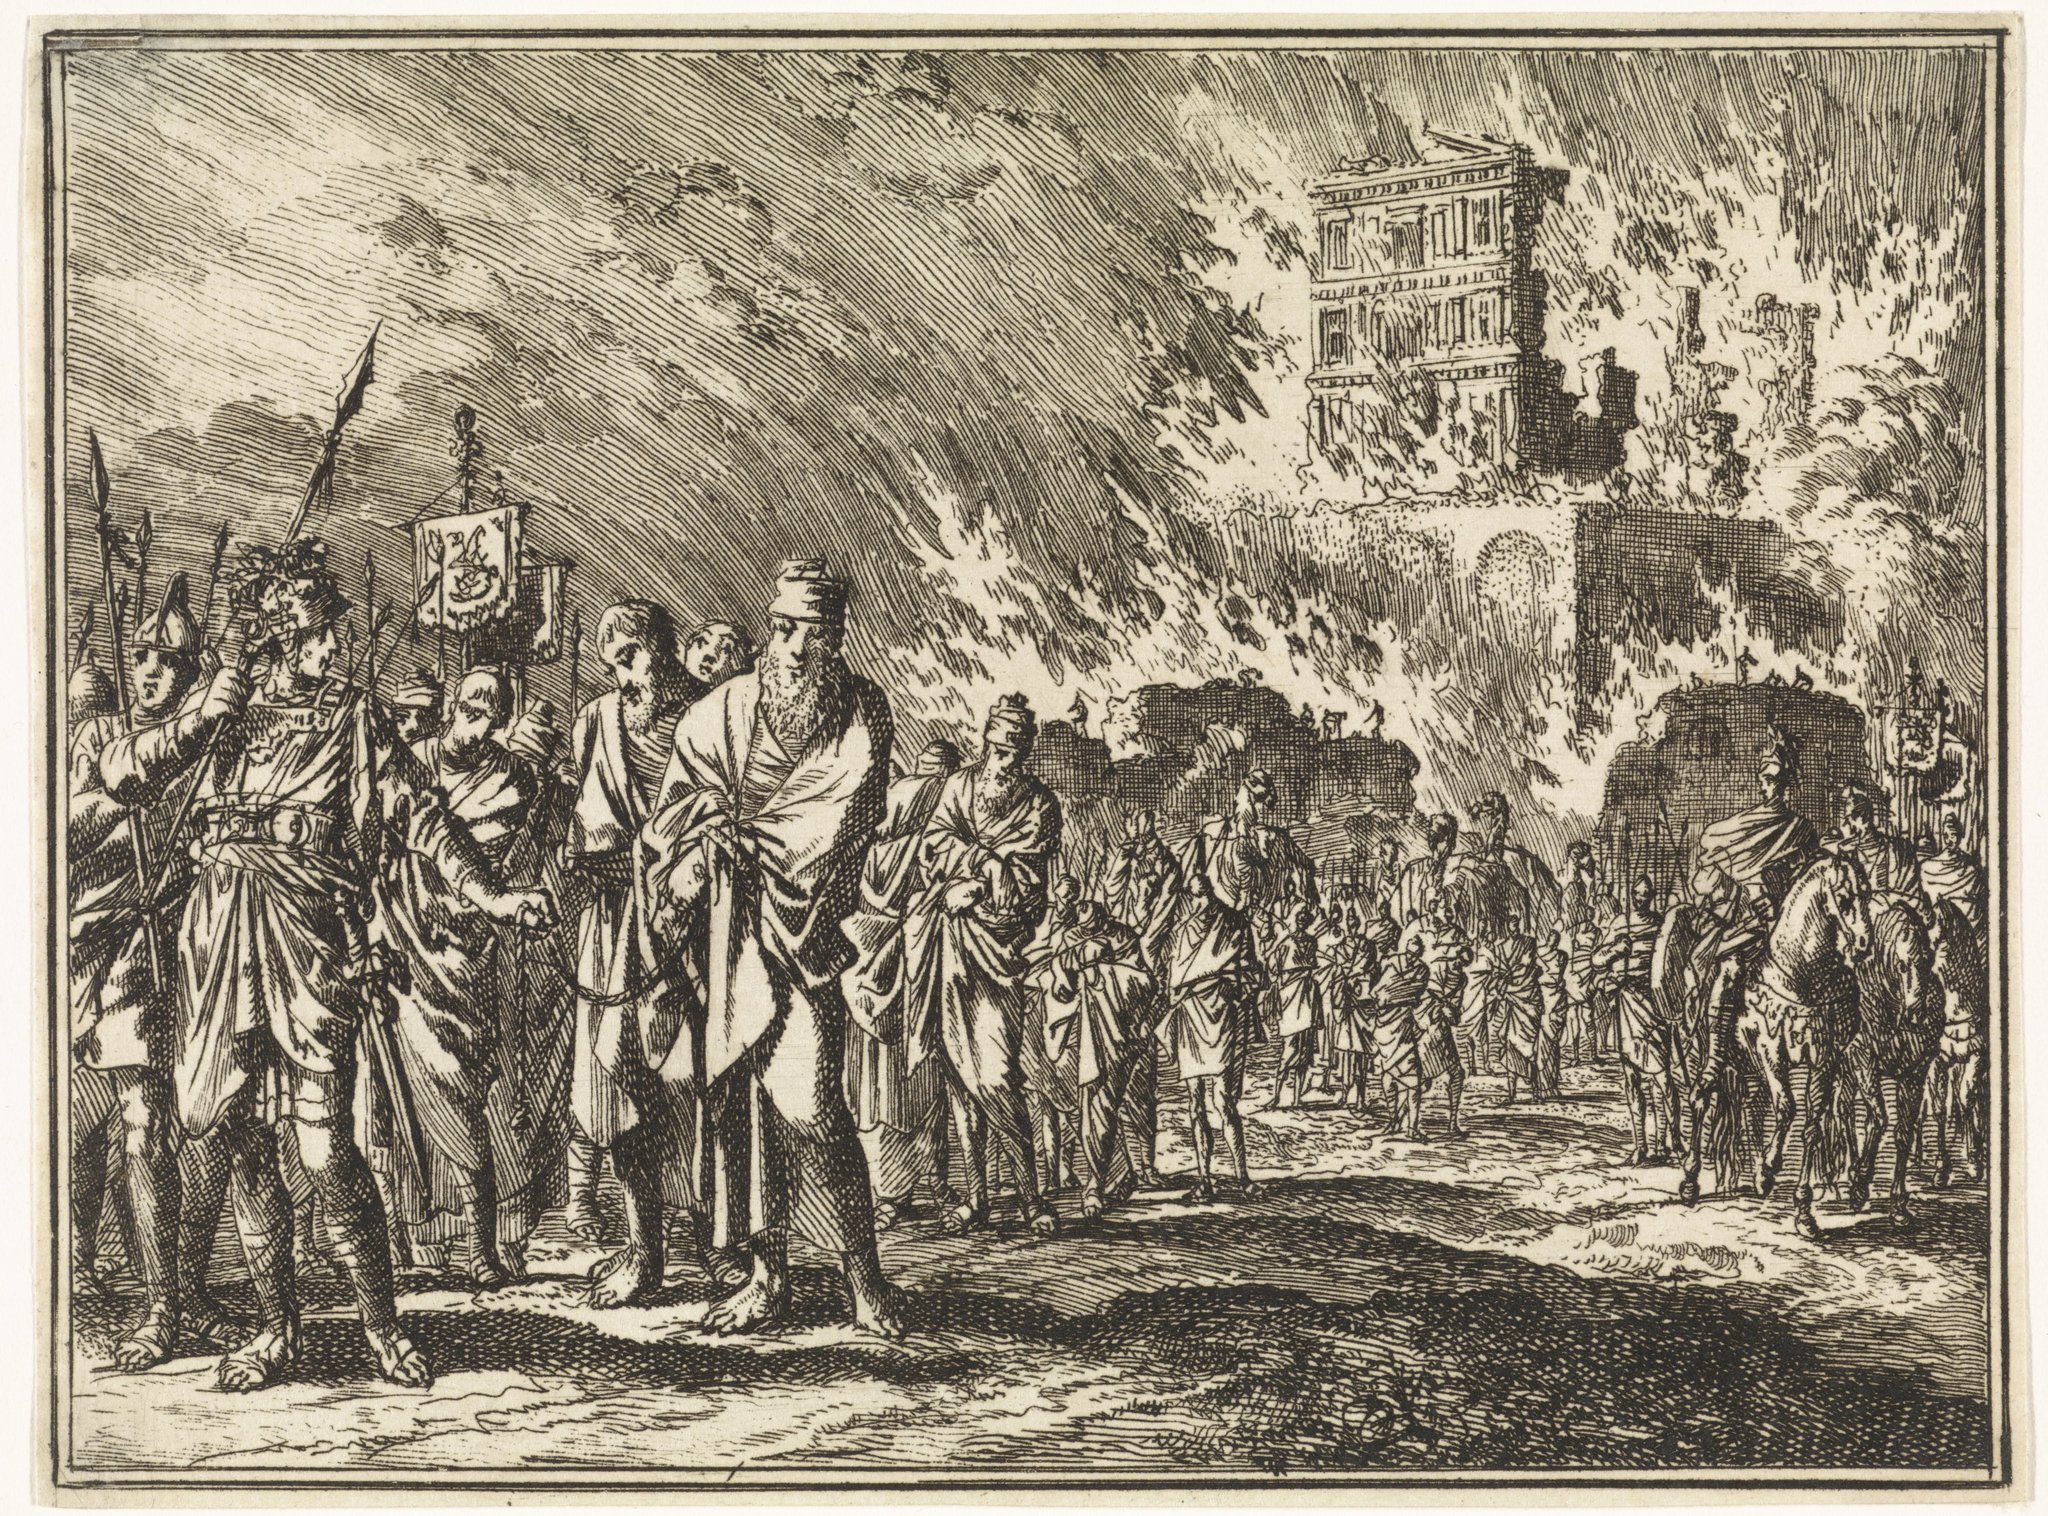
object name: print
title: Wegvoering van Juda uit het brandende Jeruzalem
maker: jan luyken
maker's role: draughtsman, print maker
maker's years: 1649-1712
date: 1712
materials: paper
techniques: etching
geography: amsterdam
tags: the fall of jerusalem ~ story of zedekiah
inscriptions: number: ‘161’, collector's mark: Lugt 2228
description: Illustratie uit: Luyken, Jan. De schriftuurlyke geschiedenissen en gelykenissen van het Oude en Nieuwe Verbond, 2 delen. Amsterdam: Wed. Pieter Arentsz II en Cornelis van der Sys, 1712, dl. I.